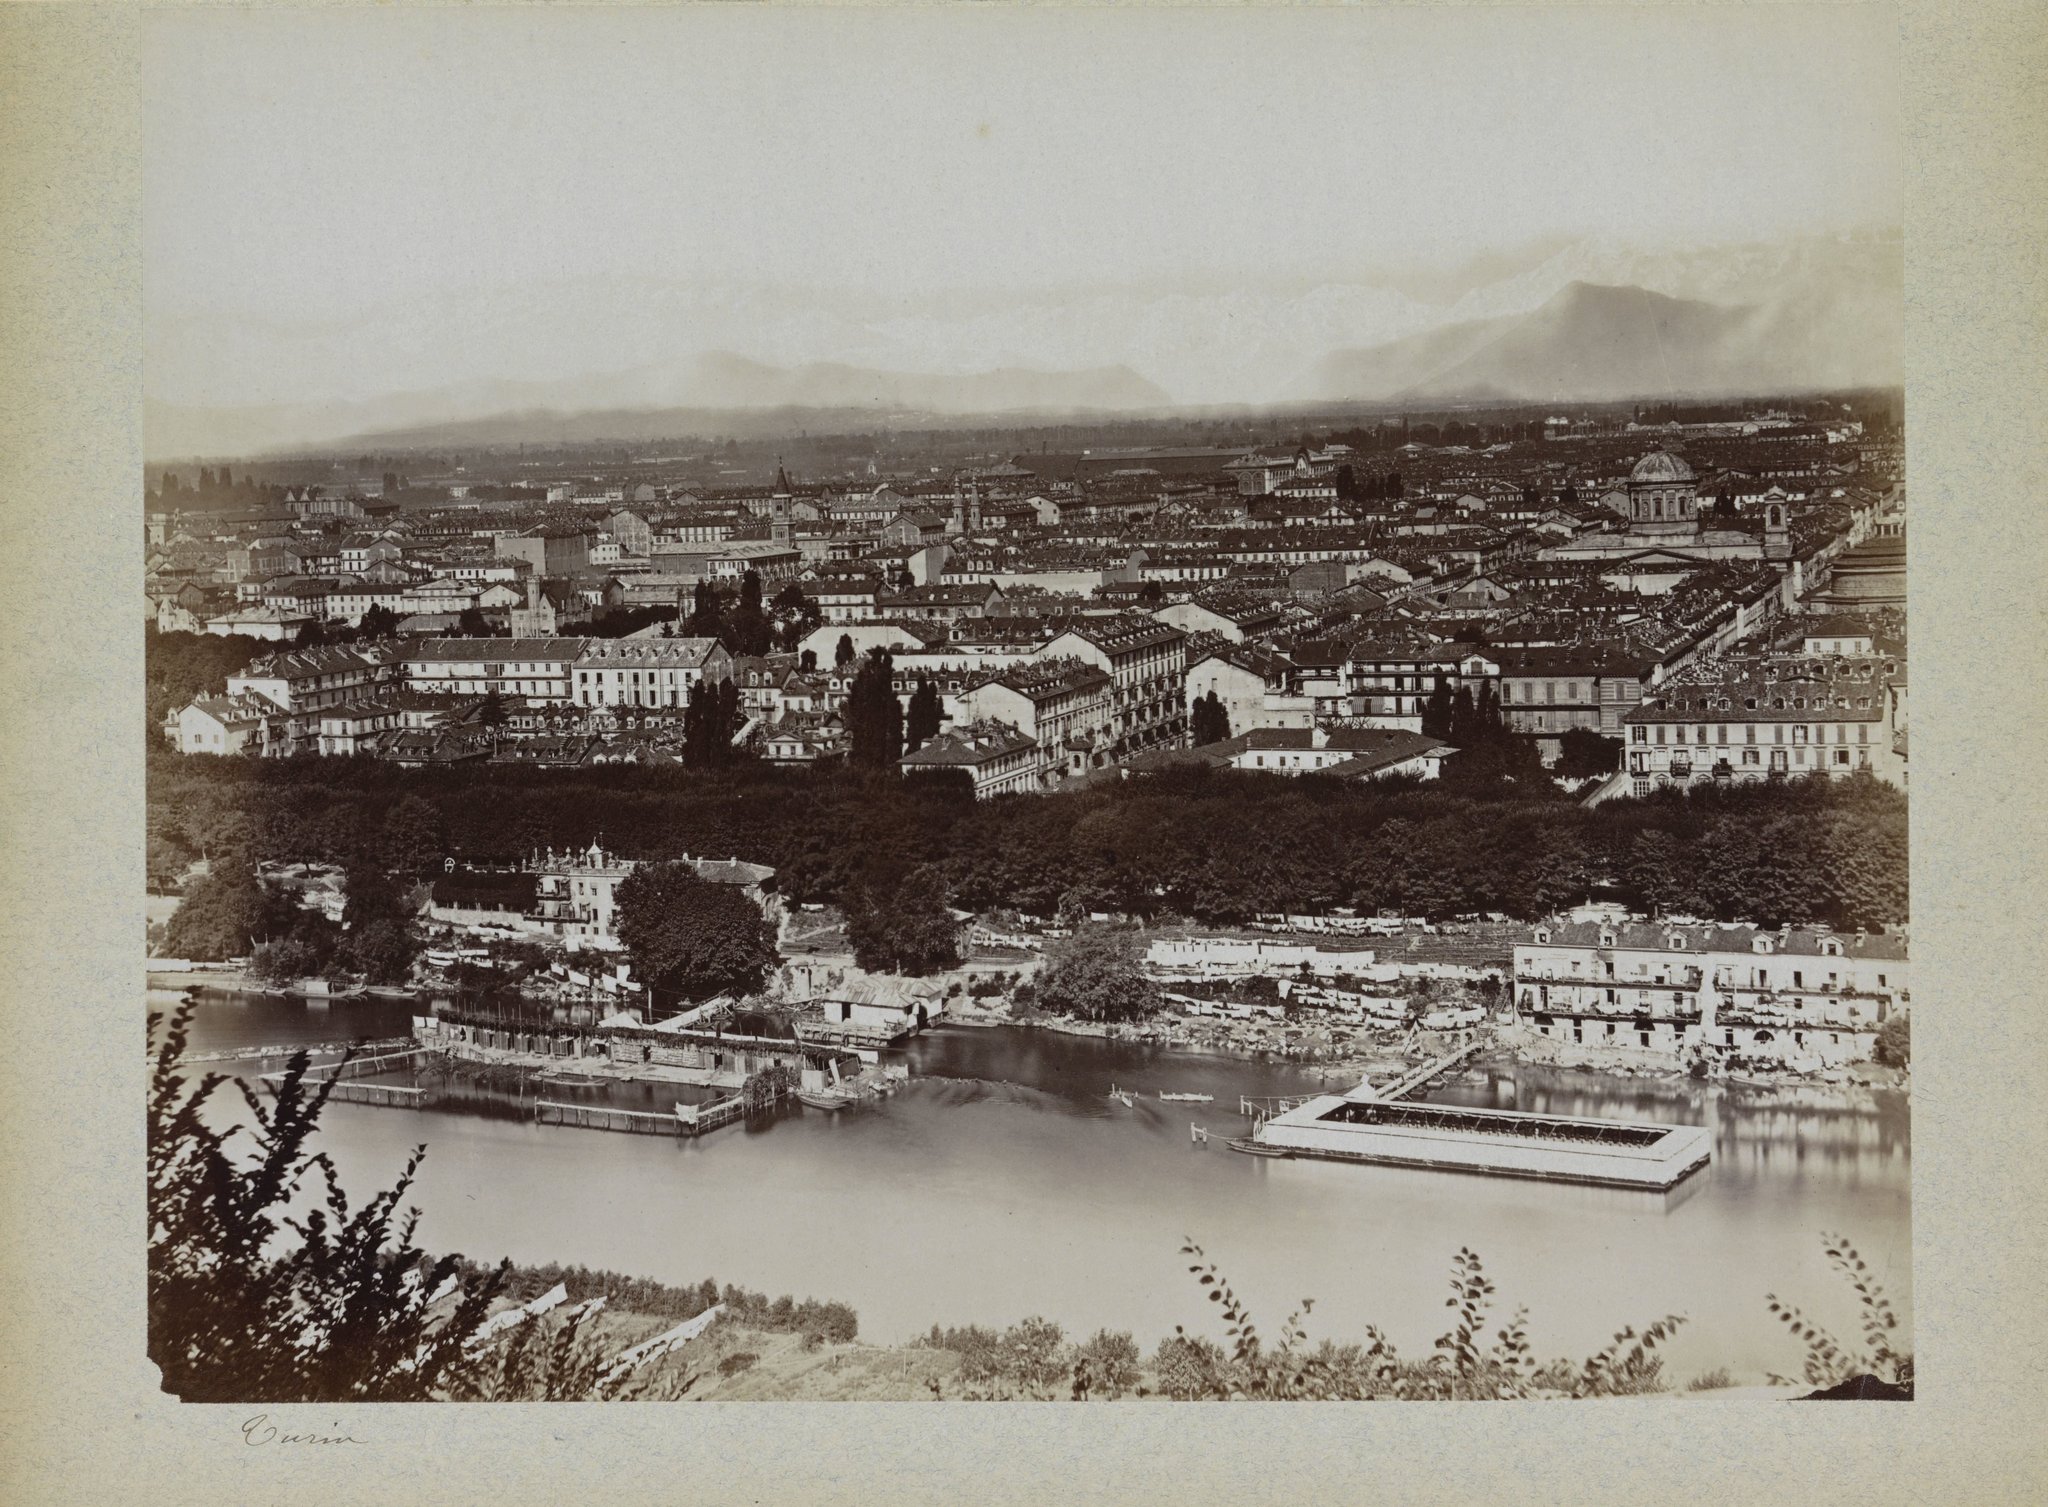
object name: photograph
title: Gezicht op Turijn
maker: Anonymous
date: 1885-1900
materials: paper, photographic support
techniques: albumen print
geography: turin